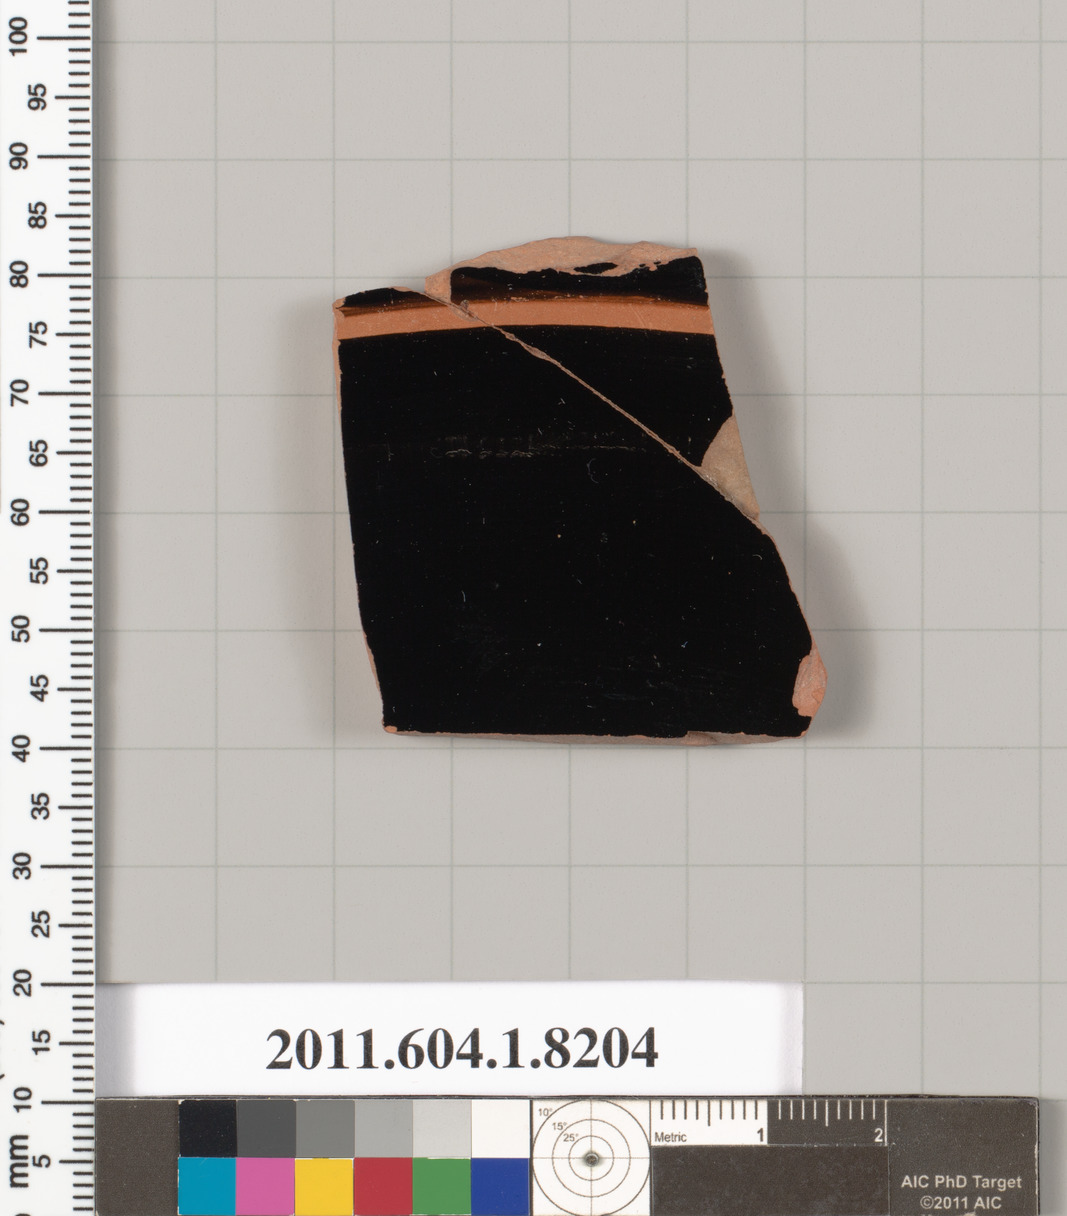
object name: kylix fragment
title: Terracotta fragment of a kylix (drinking cup)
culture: greek, attic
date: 520-510 BCE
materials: terracotta